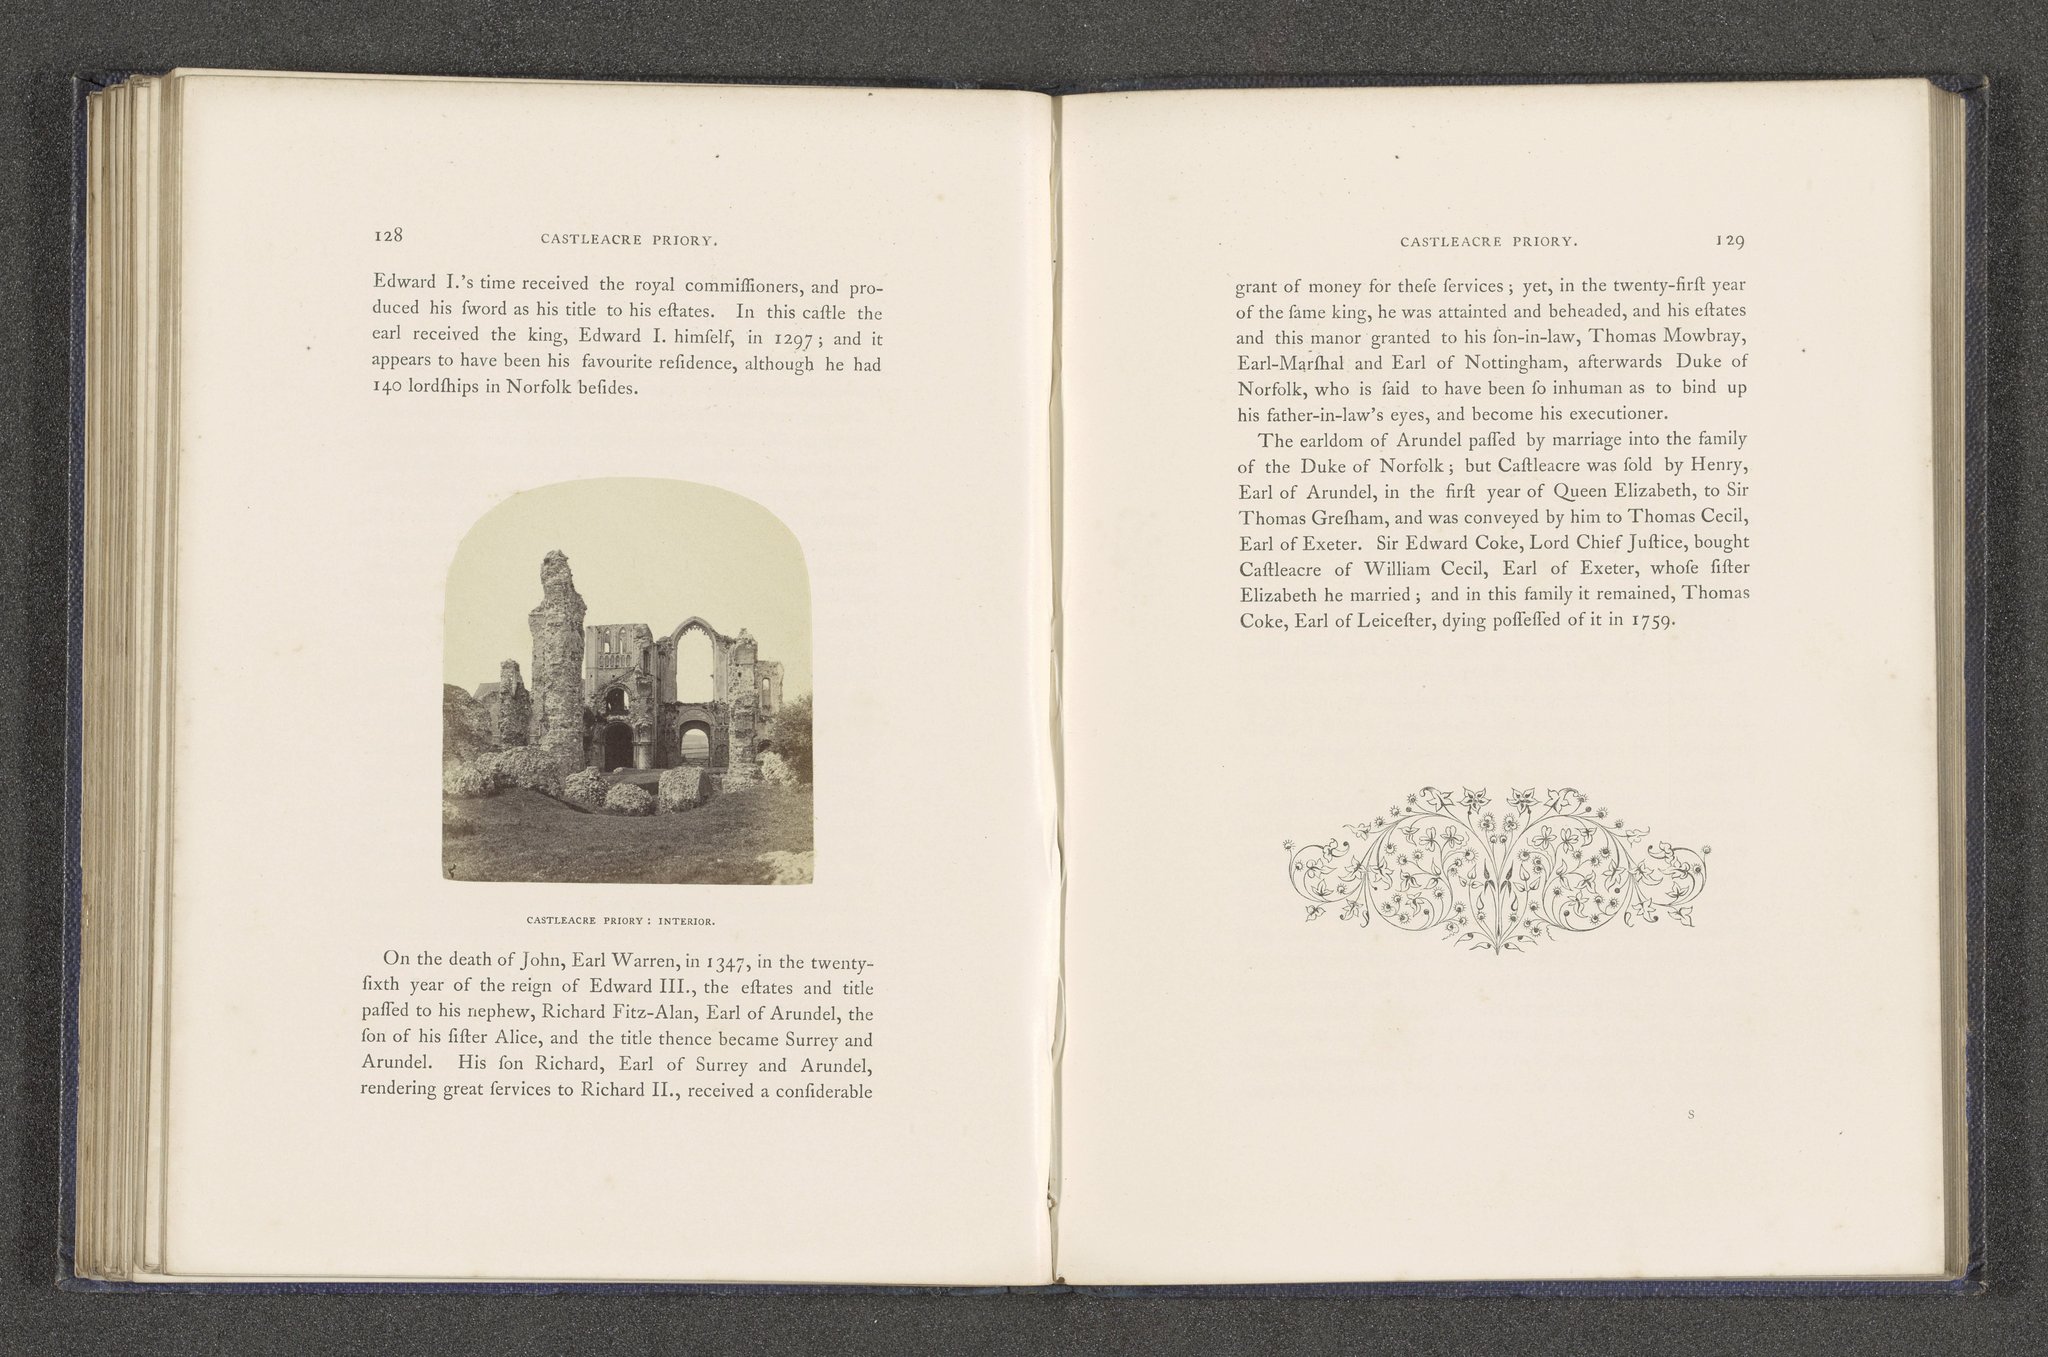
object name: photograph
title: Interieur van de ruïne van de Castle Acre Priory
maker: william russell sedgfield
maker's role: fotograaf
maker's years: 1826-1902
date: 1854-1864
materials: photographic support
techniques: albumen print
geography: castle acre priory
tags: ruin of church, monastery, etc.